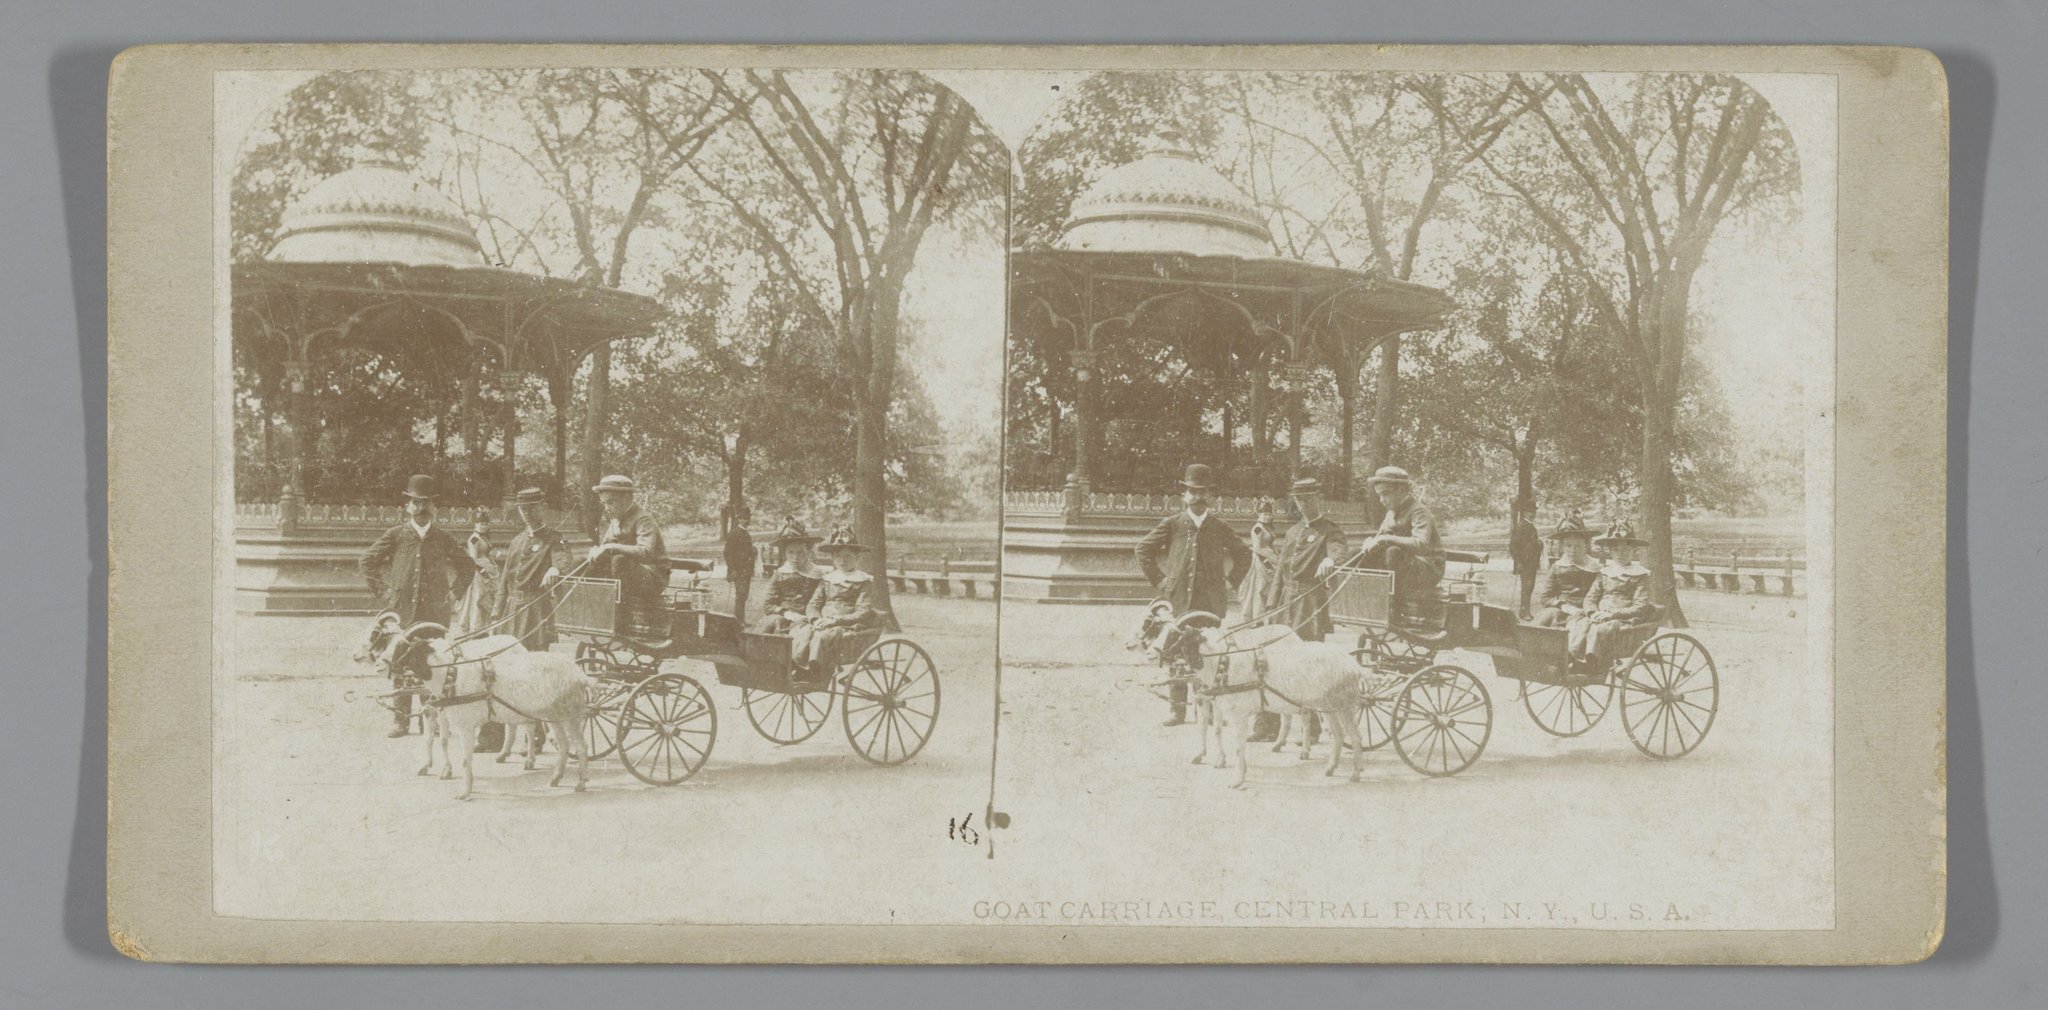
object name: stereograph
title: Rijtuig gespannen met geiten in Central Park, New York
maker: Anonymous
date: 1879-1910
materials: paper, cardboard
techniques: gelatin silver print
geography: central park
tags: passenger carriage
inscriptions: number: ‘16’